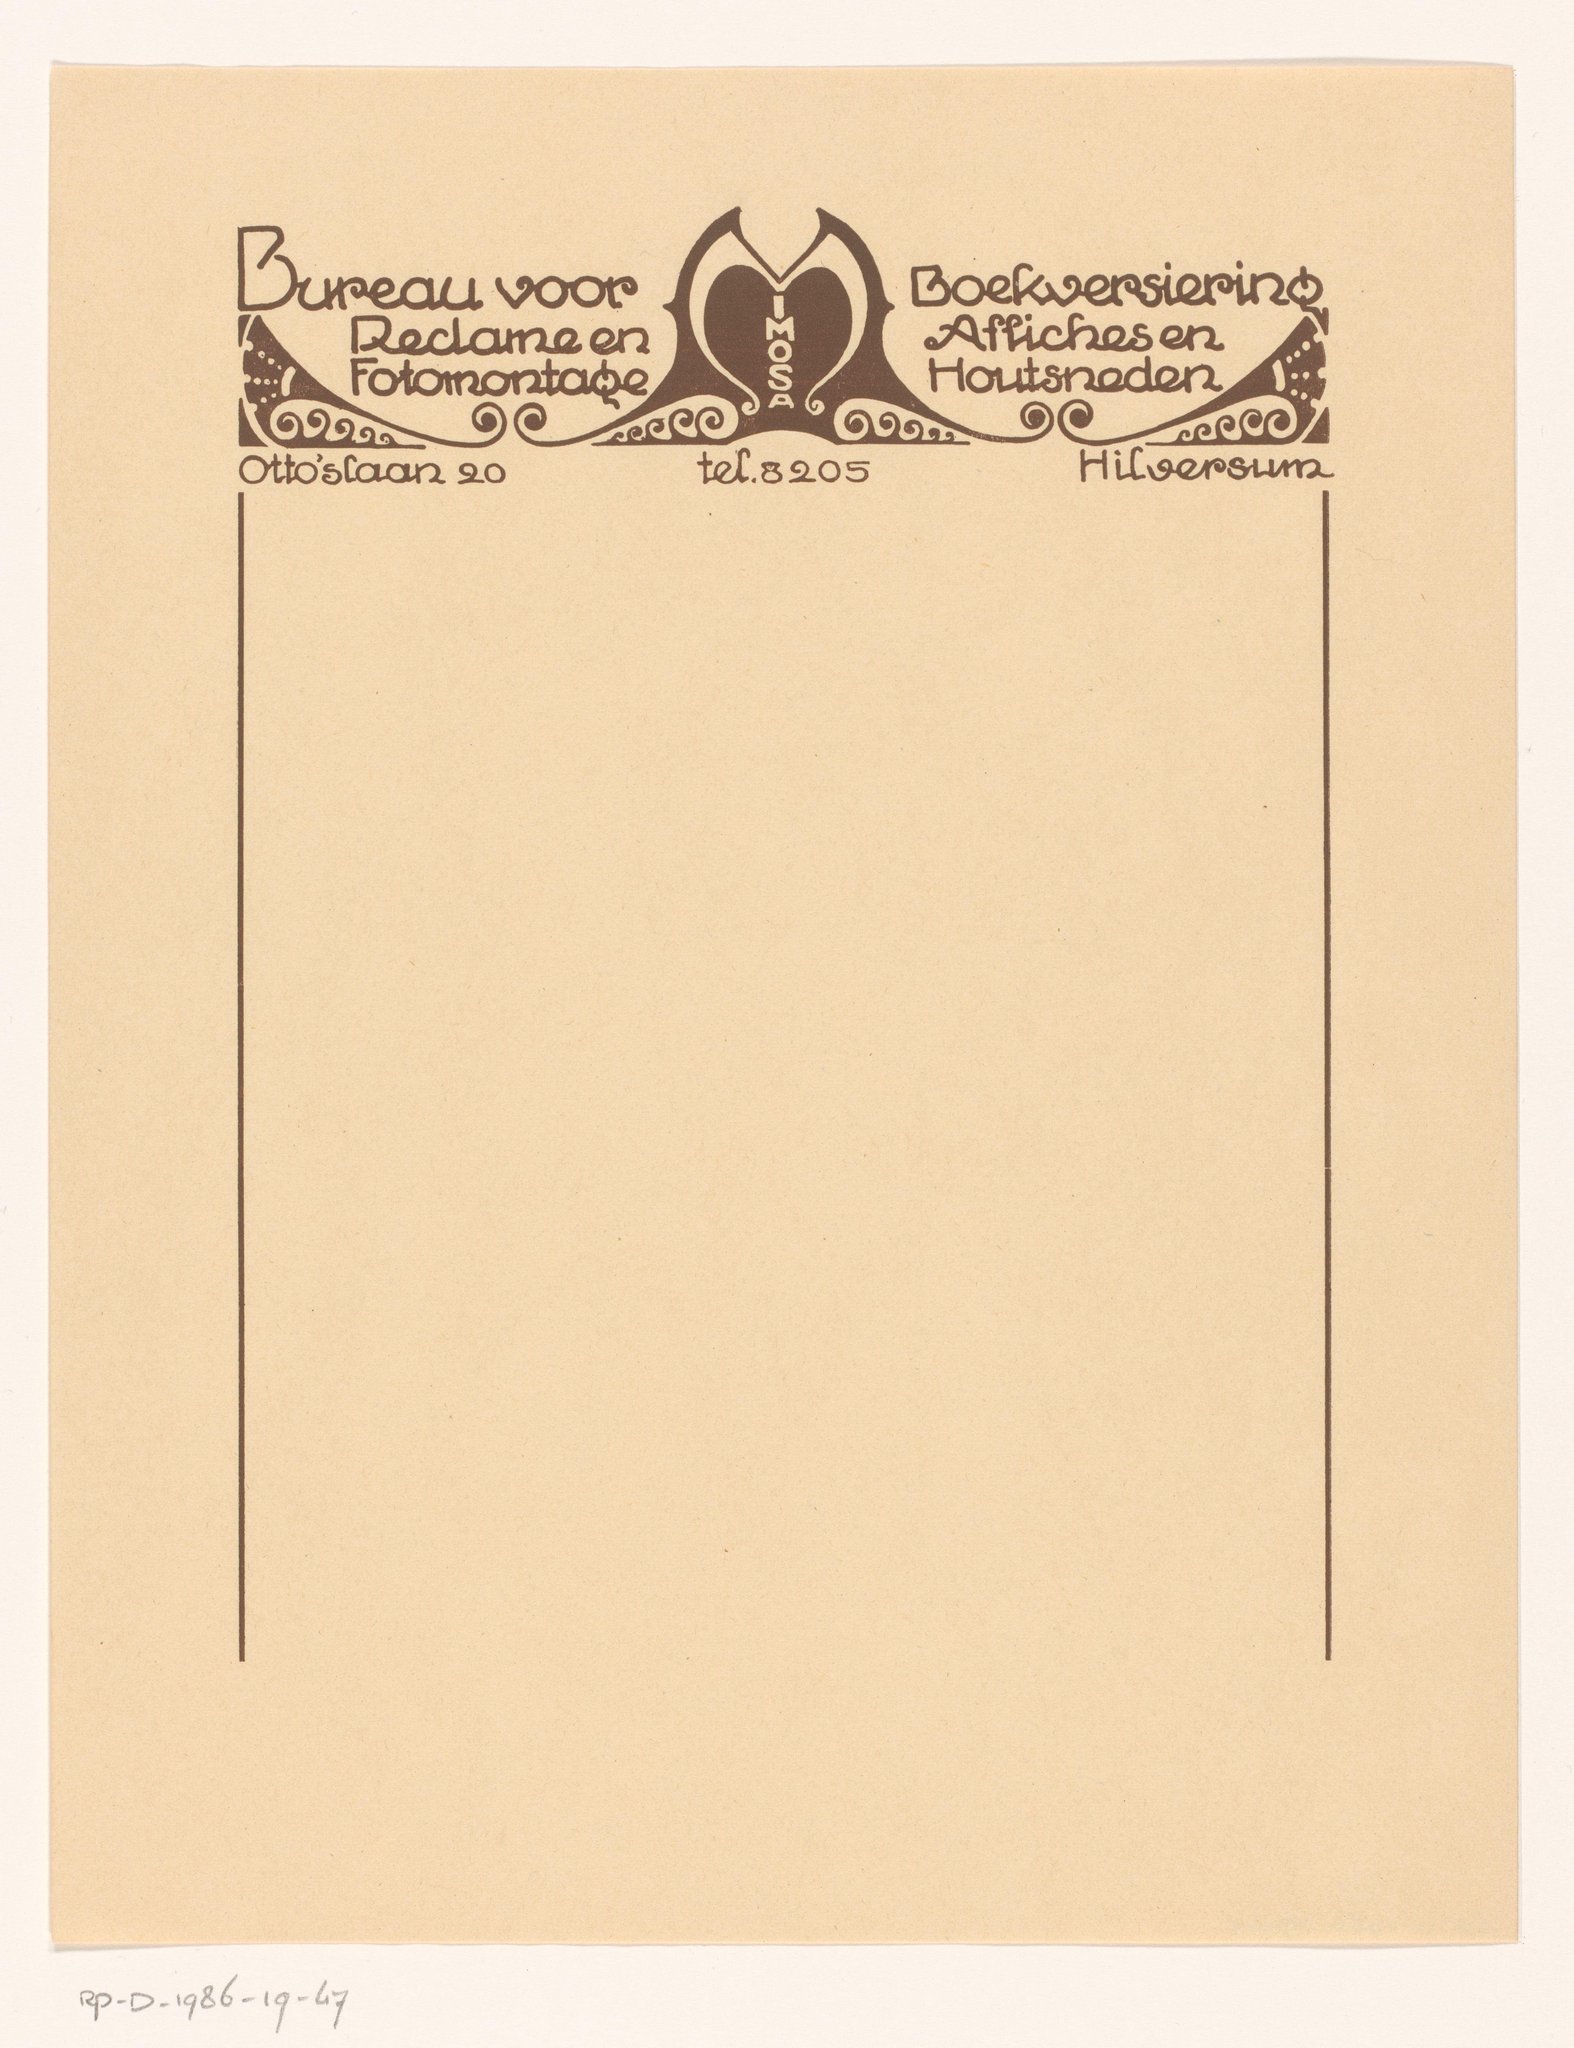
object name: stationery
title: Briefpapier van Bureau voor Boekversiering Mimosa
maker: reinier willem petrus de vries (1874-1953)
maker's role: draughtsman, print maker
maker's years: 1874-1953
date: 1884-1952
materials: paper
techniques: relief print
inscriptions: collector's mark: ‘R:MVS.’